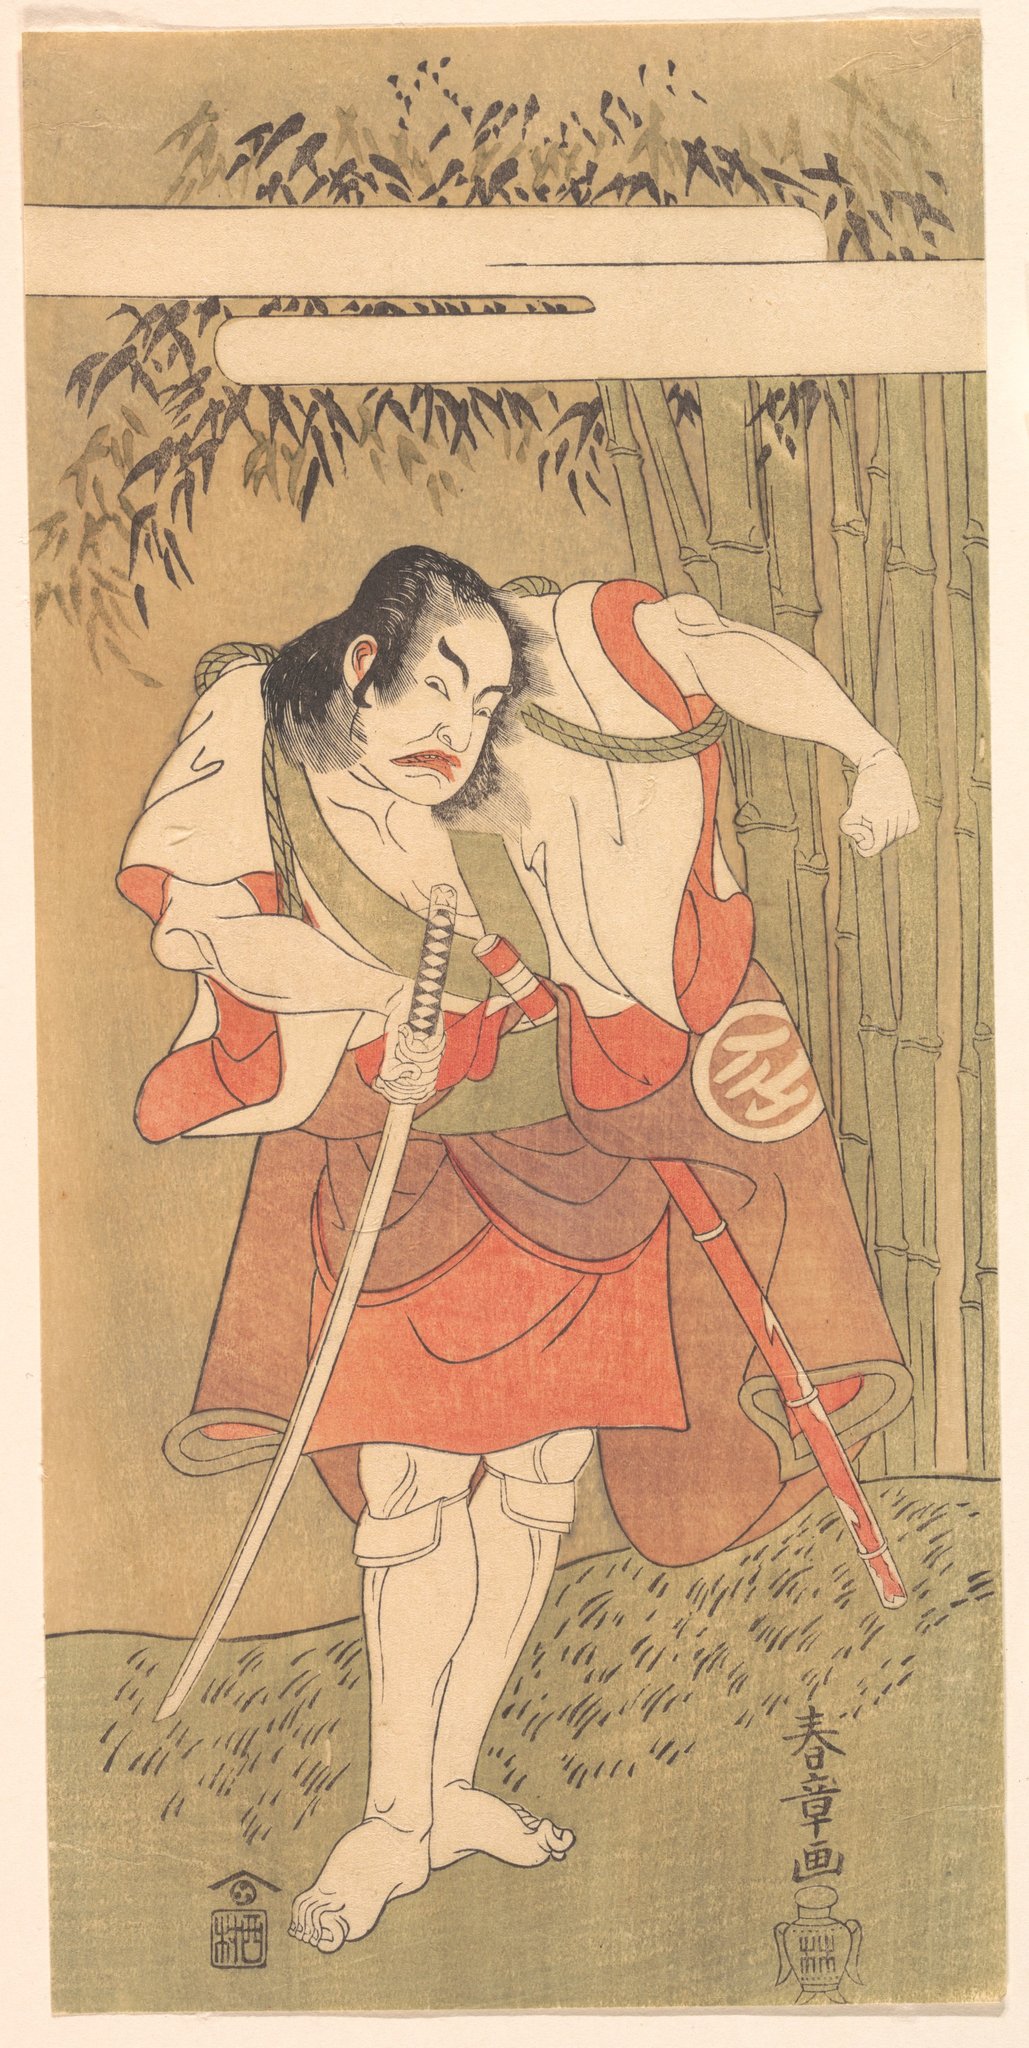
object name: woodblock print nishiki e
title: The Actor Nakamura Sukegoro I with His Sword Drawn in a Defiant Attitude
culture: japanese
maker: katsukawa shunshō 勝川春章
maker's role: artist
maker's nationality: japanese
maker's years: 1726-1792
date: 1726-1792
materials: ink, paper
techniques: nishiki e, woodblock print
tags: swords,men,actors